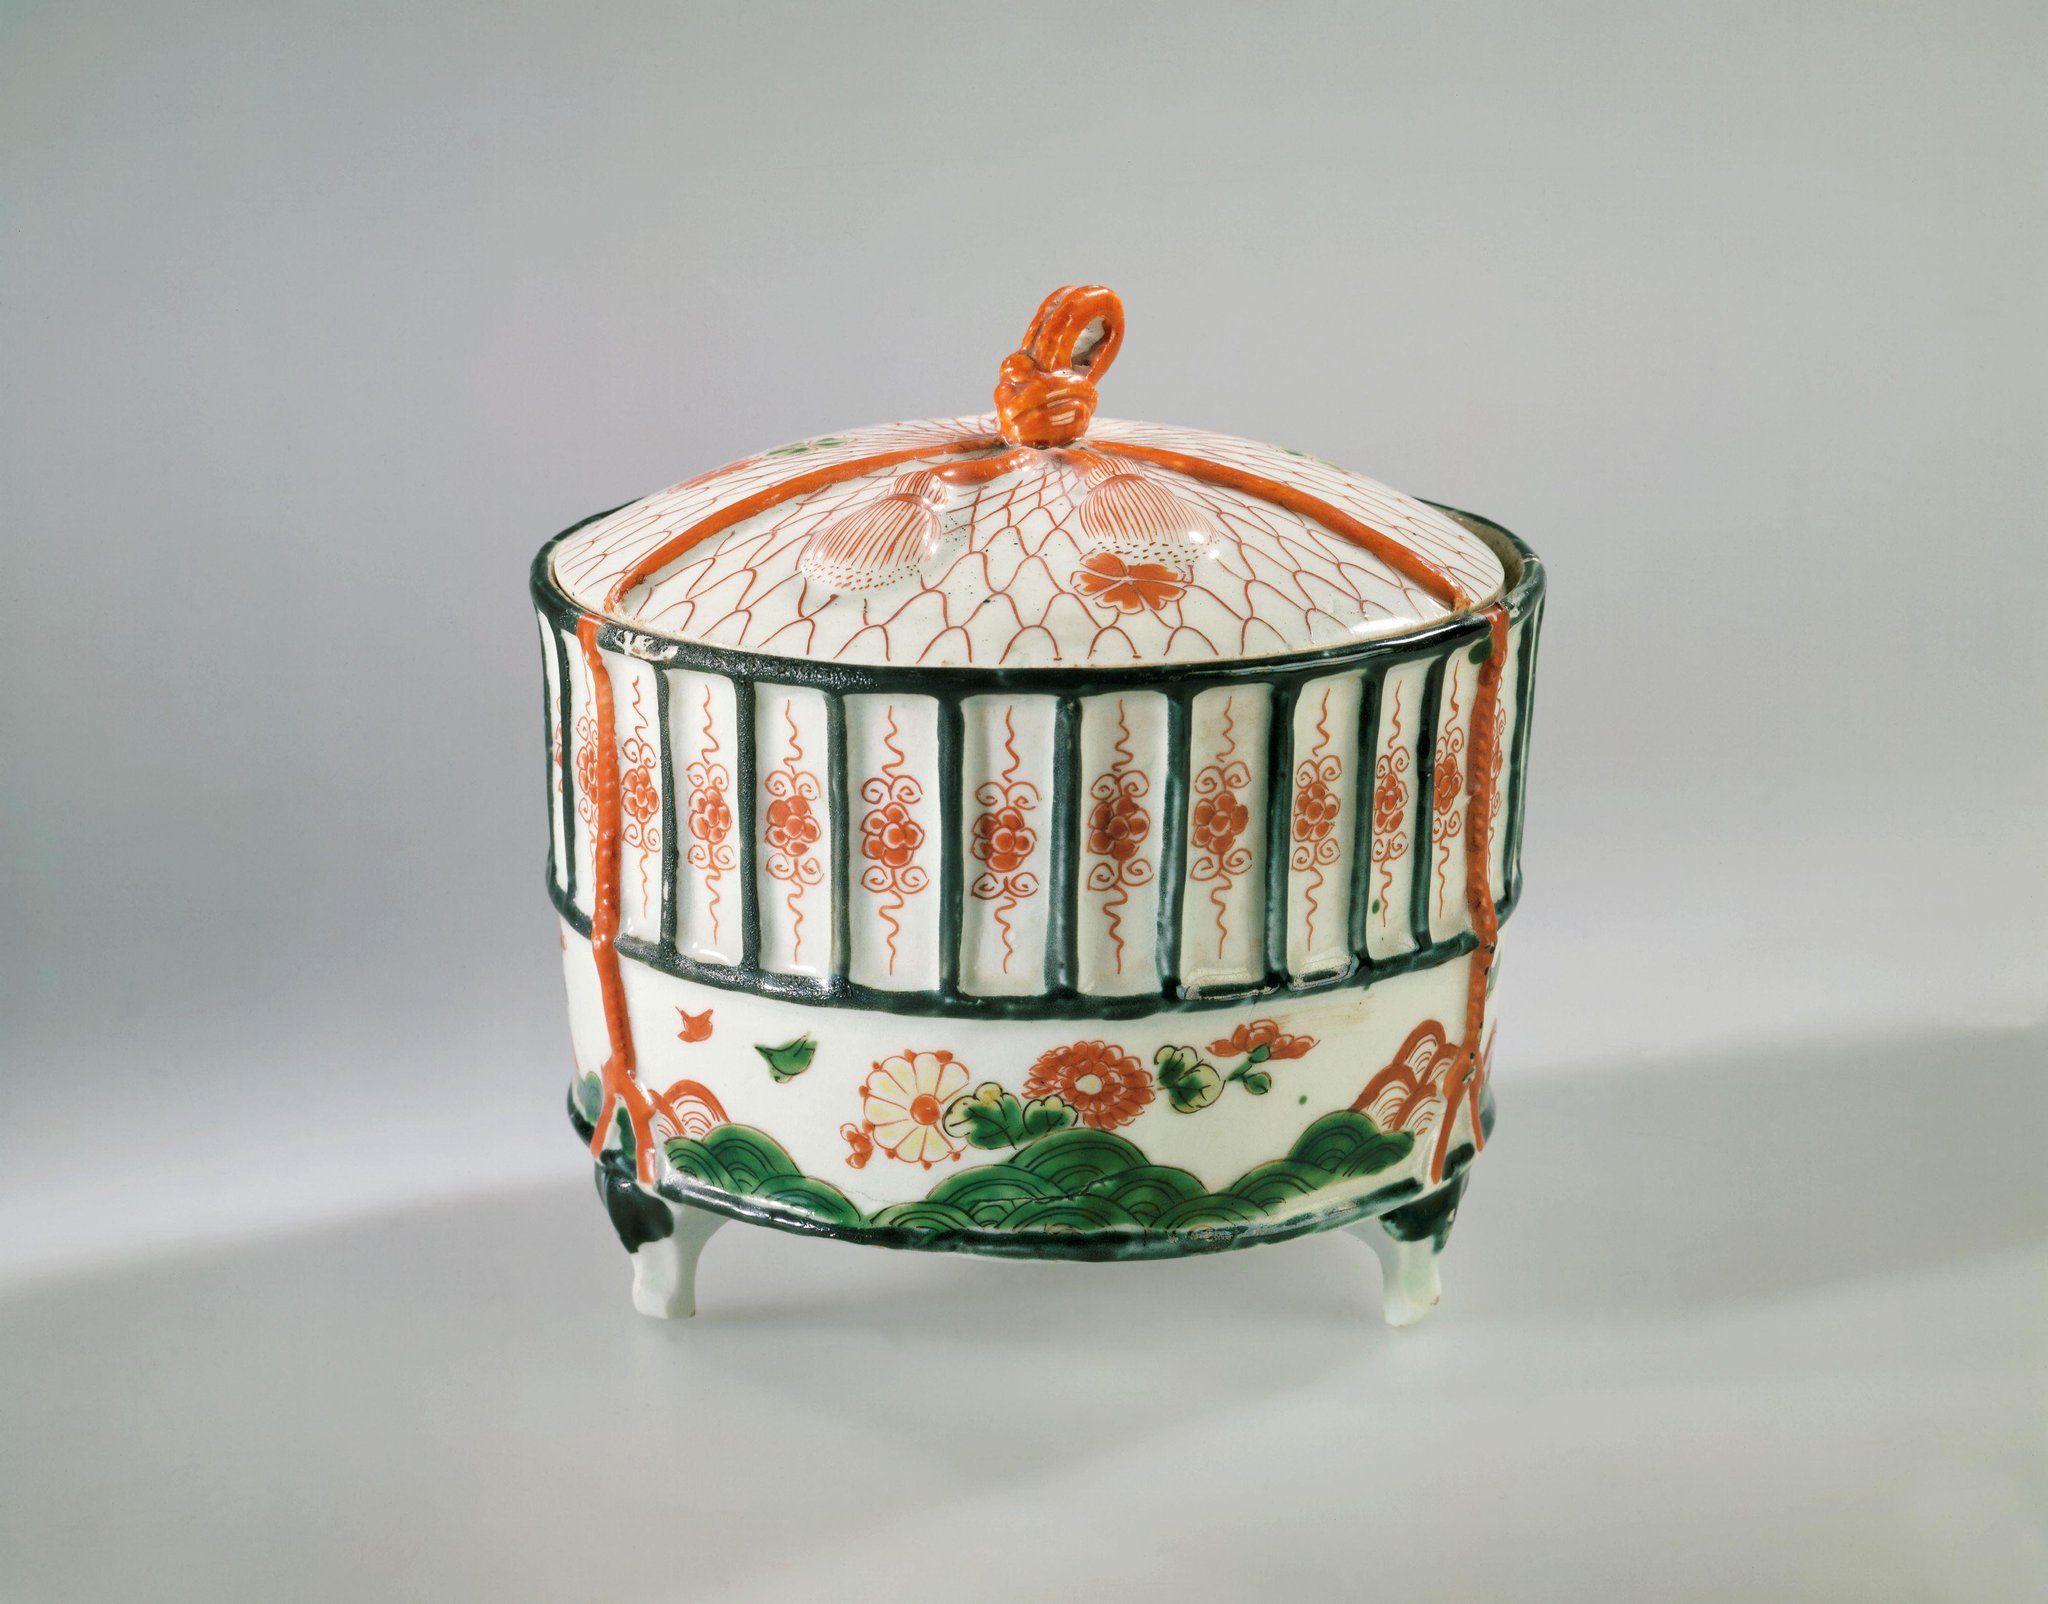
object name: box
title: Cilidrical covered box in the shape of a cricket's cage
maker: Anonymous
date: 1675-1699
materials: cobalt, glaze, paint, porcelain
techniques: firing, forming, turning, vitrification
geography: japan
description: Cilindrische doos van porselein op drie poten en in de vorm van een krekelkooi bijeengehouden door drie gemodelleerde koorden, eindigend in een opstaande knoop als dekselknop. Beschilderd in onderglazuur blauw en op het glazuur rood, groen, geel en zwart. De onderste helft van de doos met golven, vogels en bloemtakken; de bovenste helft is gemodelleerd in traliewerk met in elk vak een bloemrank. Imari.